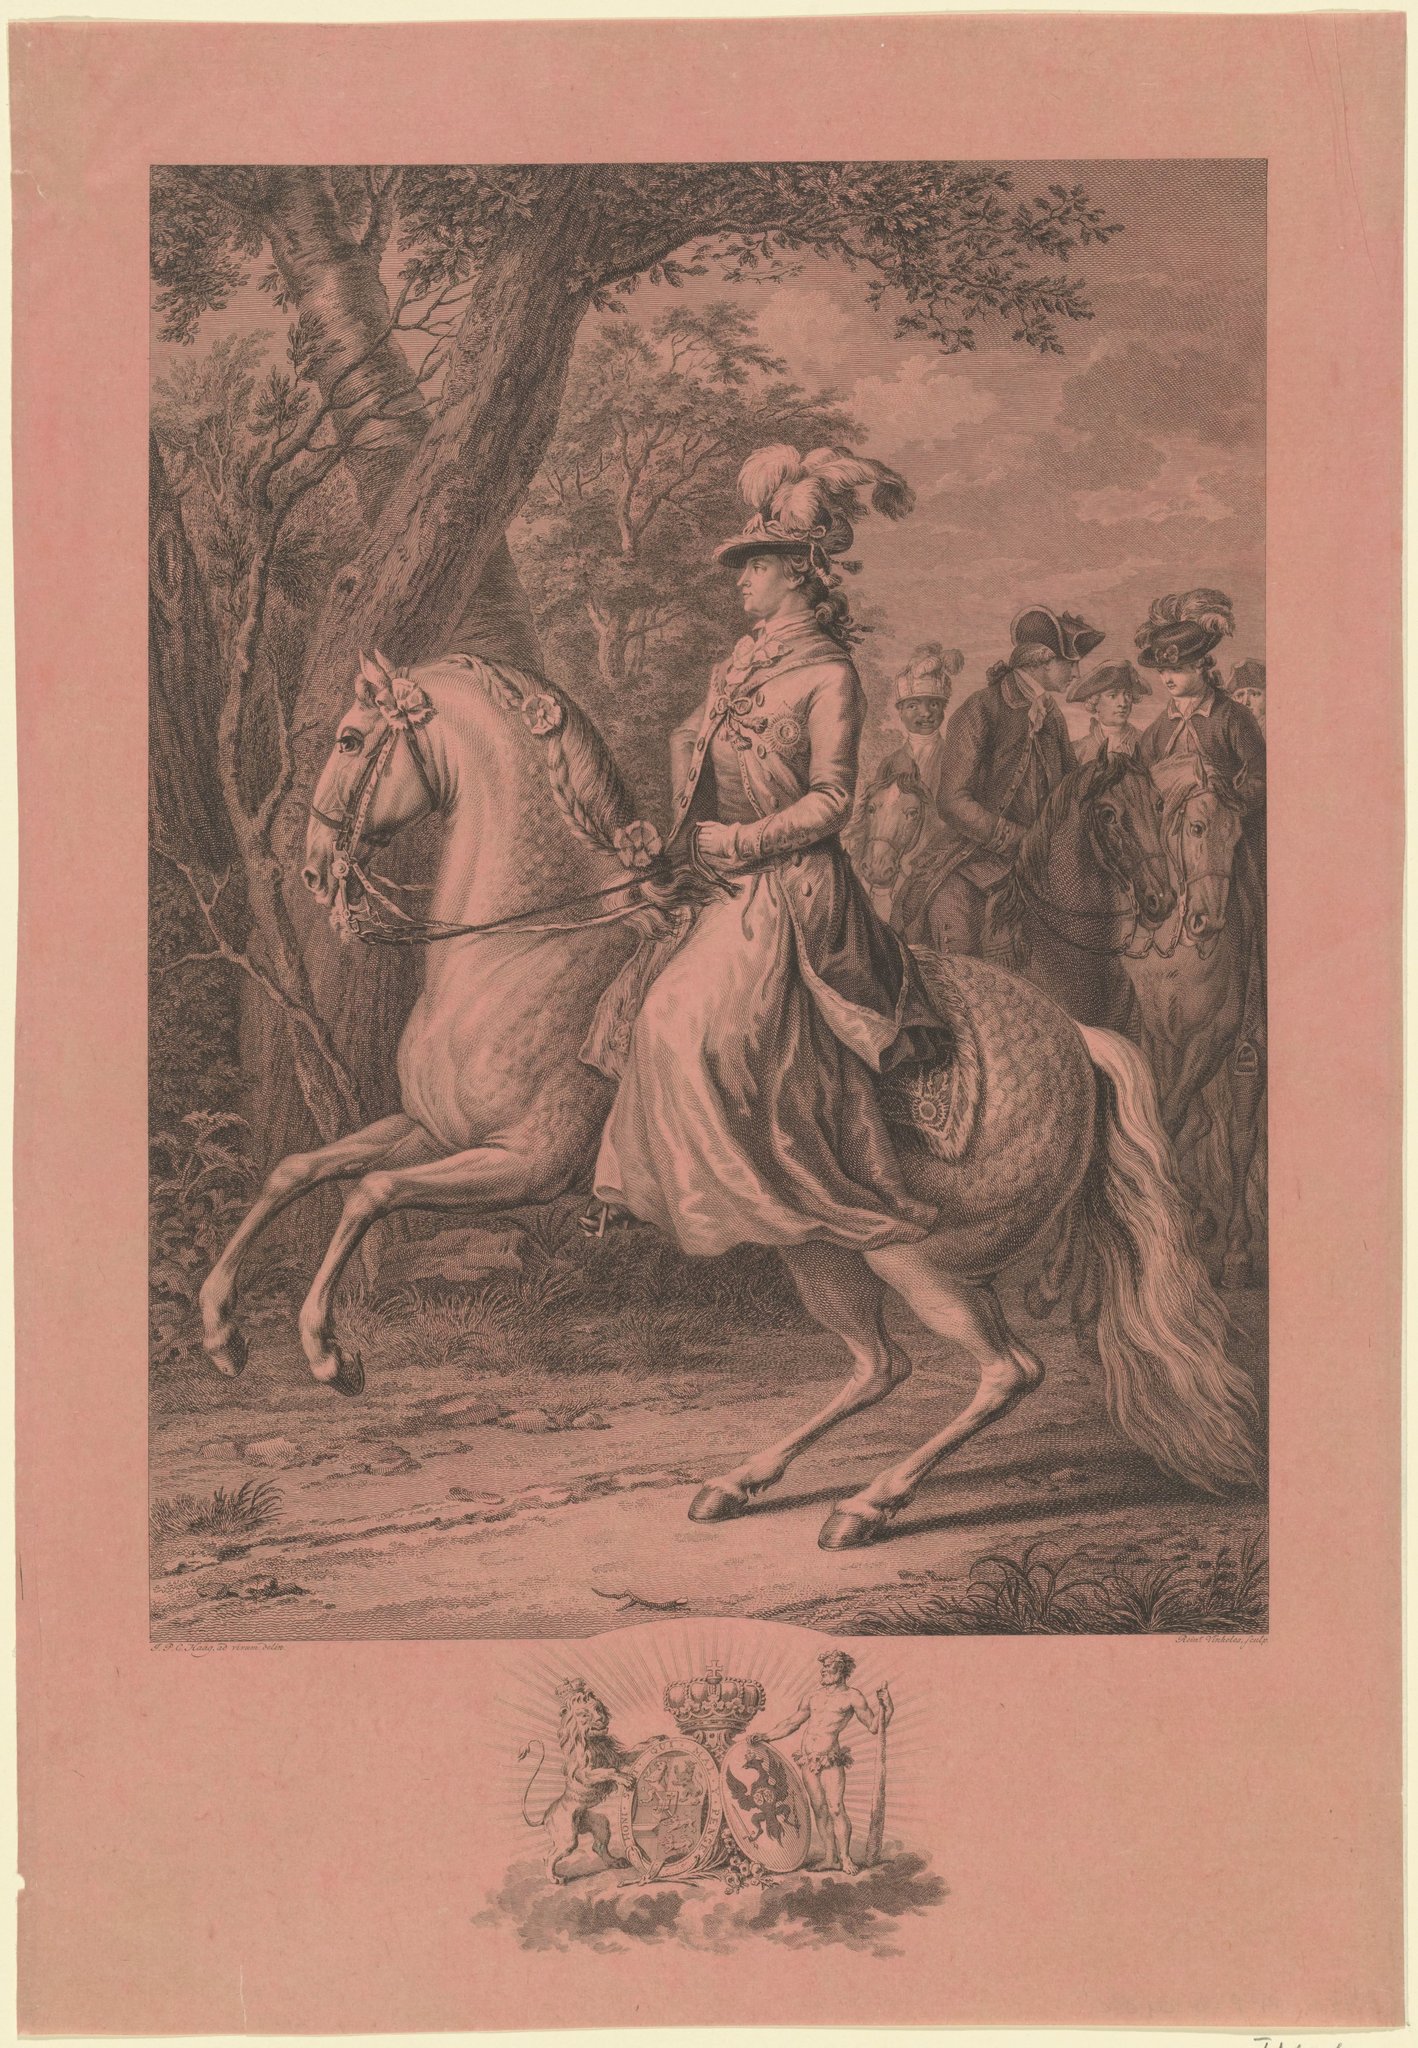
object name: print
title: Ruiterportret van Wilhelmina van Pruisen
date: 1767-1816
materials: paper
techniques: engraving, etching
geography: amsterdam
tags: the hague, william v (prince of orange), wilhelmina of prussia (princess of orange), knighthood order (garter) - insignia of a knighthood order, e.g.: badge, chain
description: Ruiterportret van Wilhelmina. Midden onder haar wapen en het wapen van Willem V, gedecoreerd met de Kousenband en het devies van de Orde van de Kousenband, met een kroon, een leeuw en Hercules.